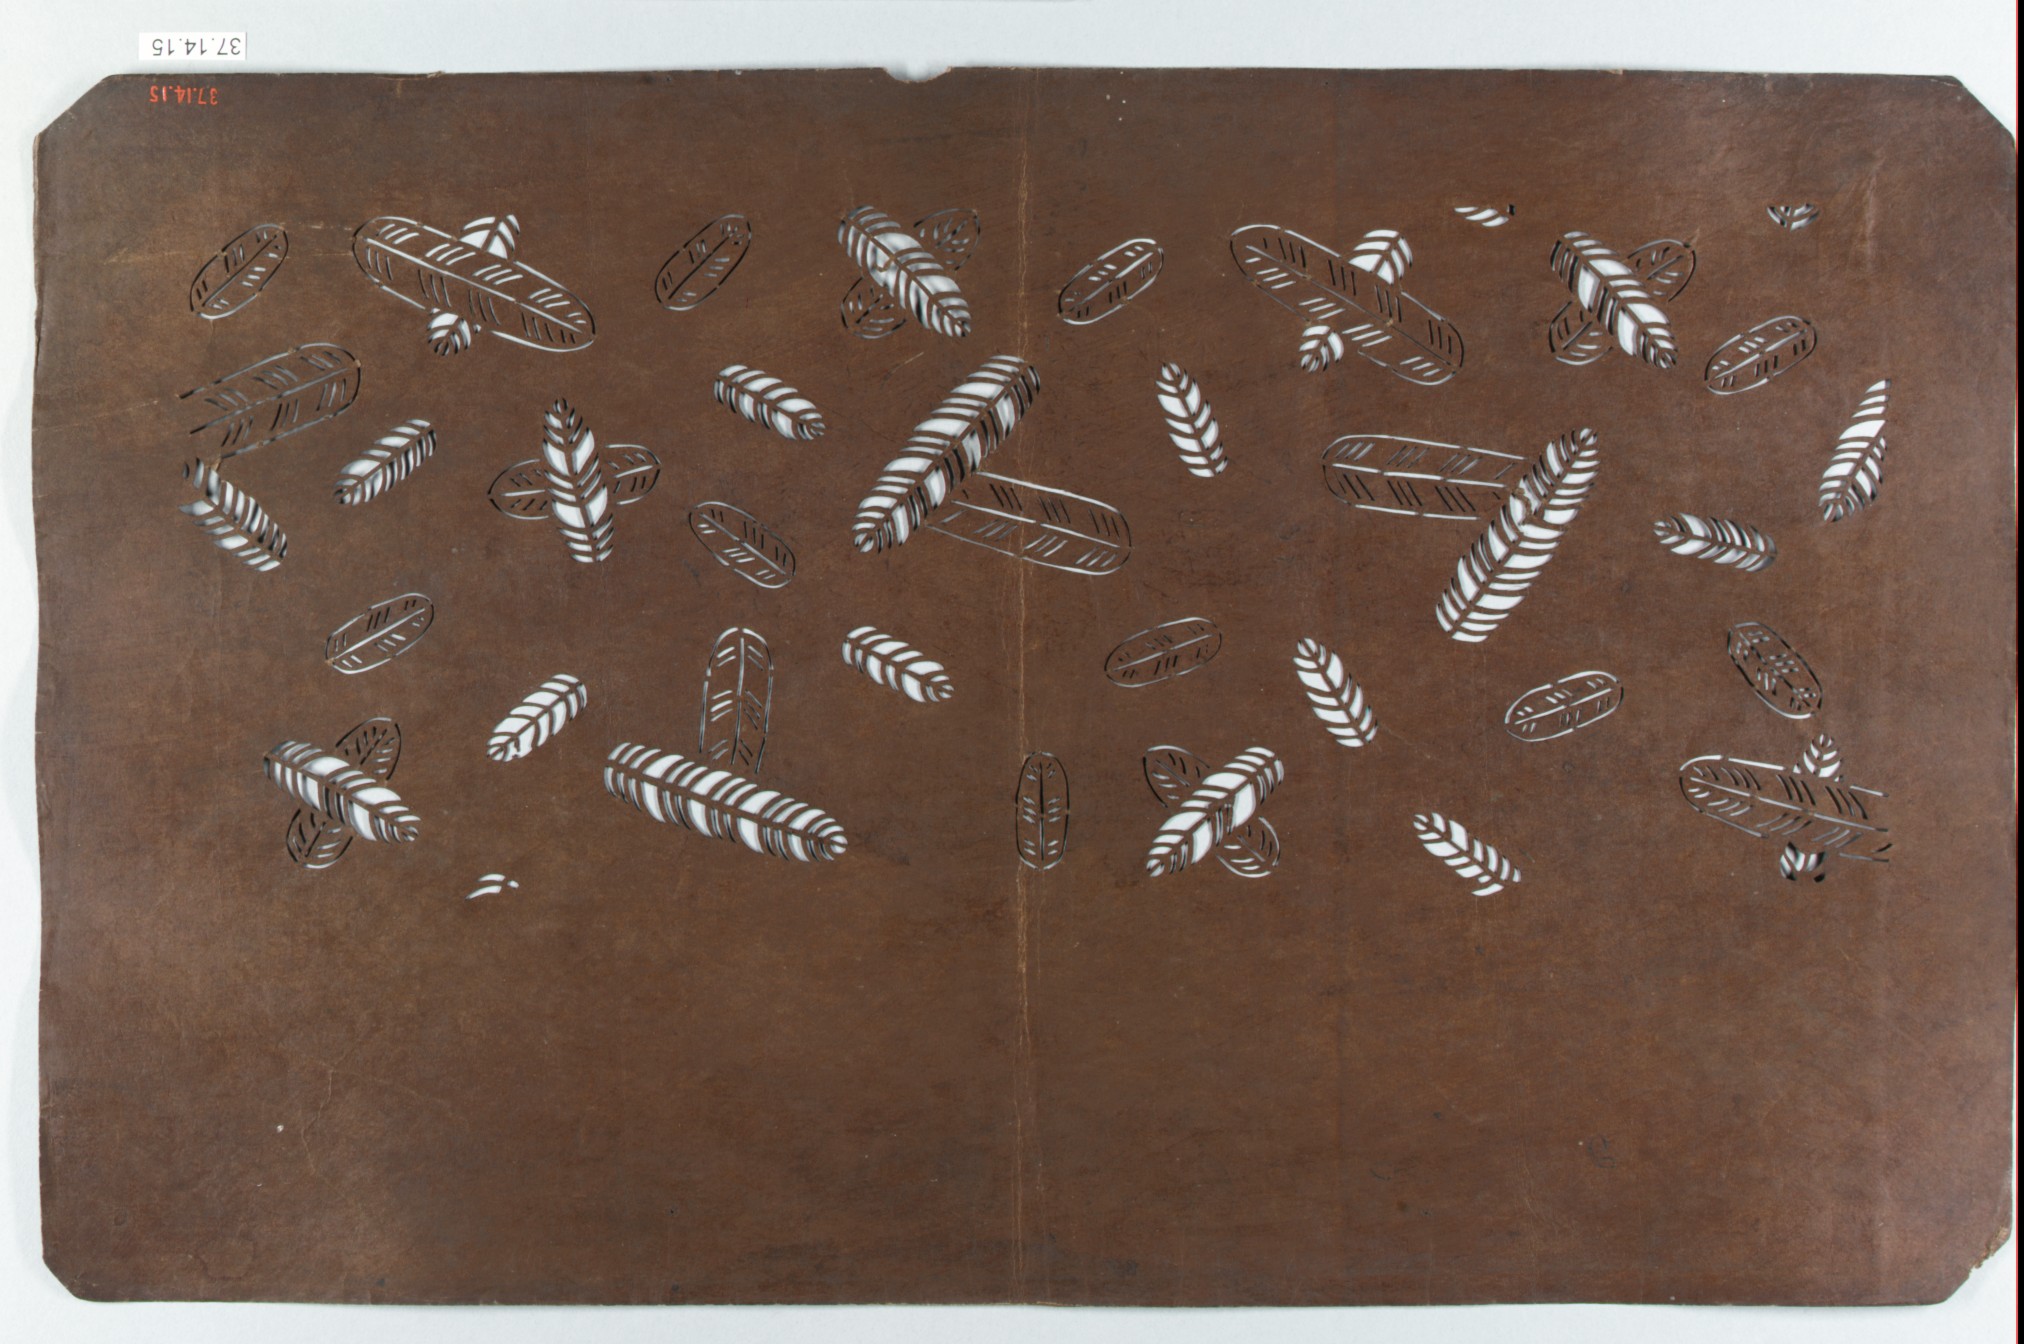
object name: stencil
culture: japanese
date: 1801-1833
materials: paper